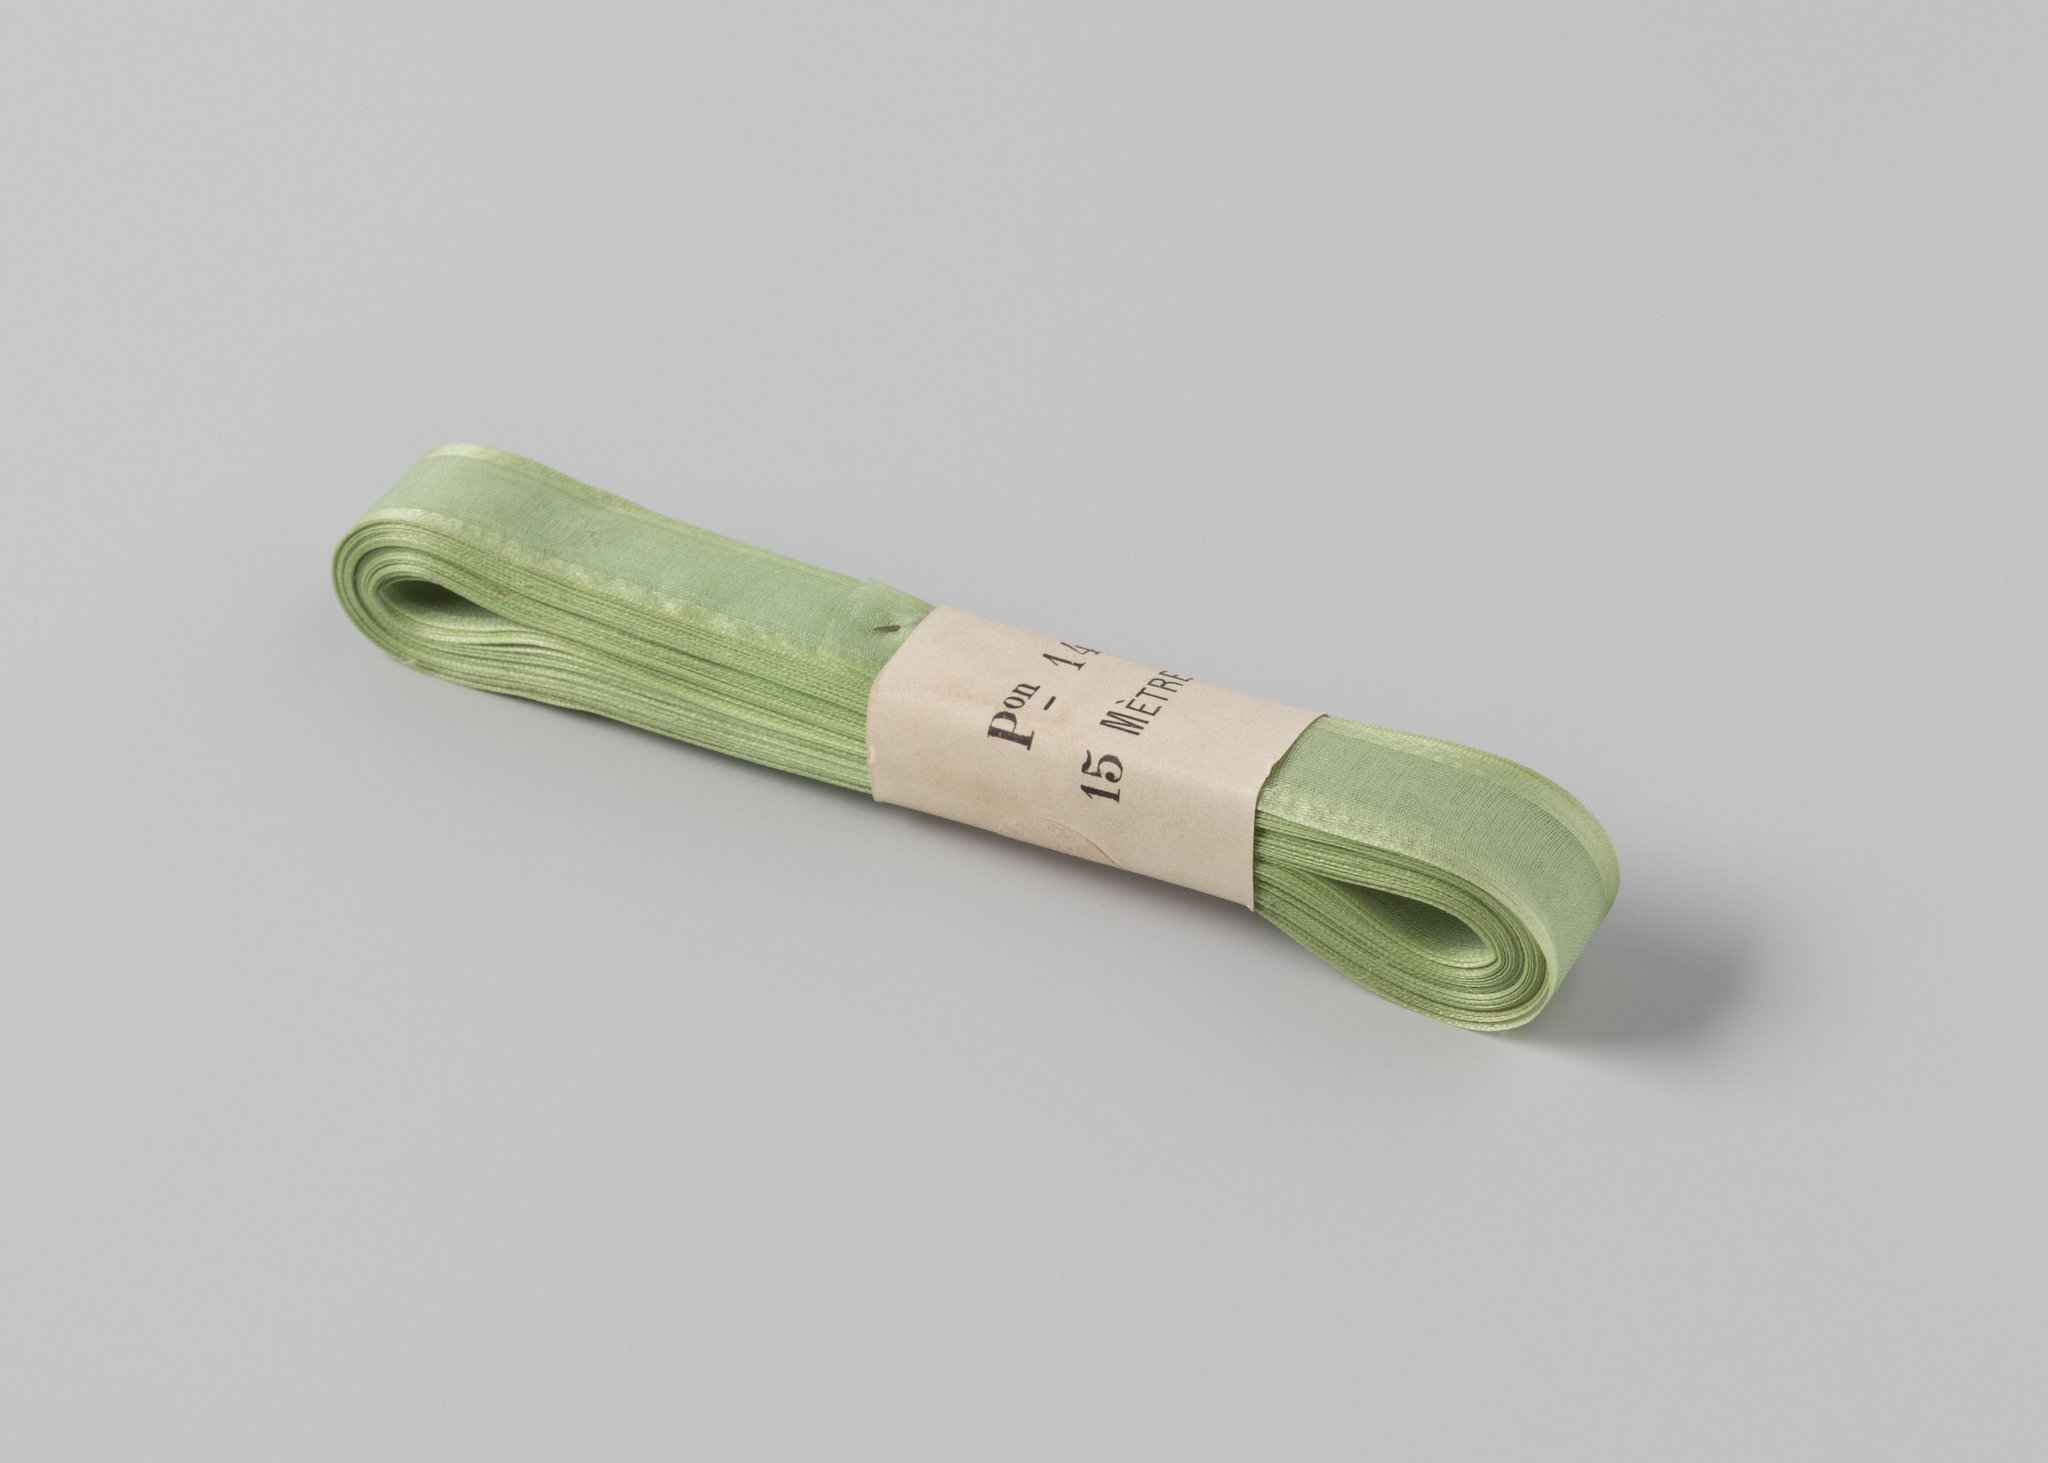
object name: ribbon material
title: Lint van lichtgroen gaas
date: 1900-1915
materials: textile, silk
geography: nijmegen